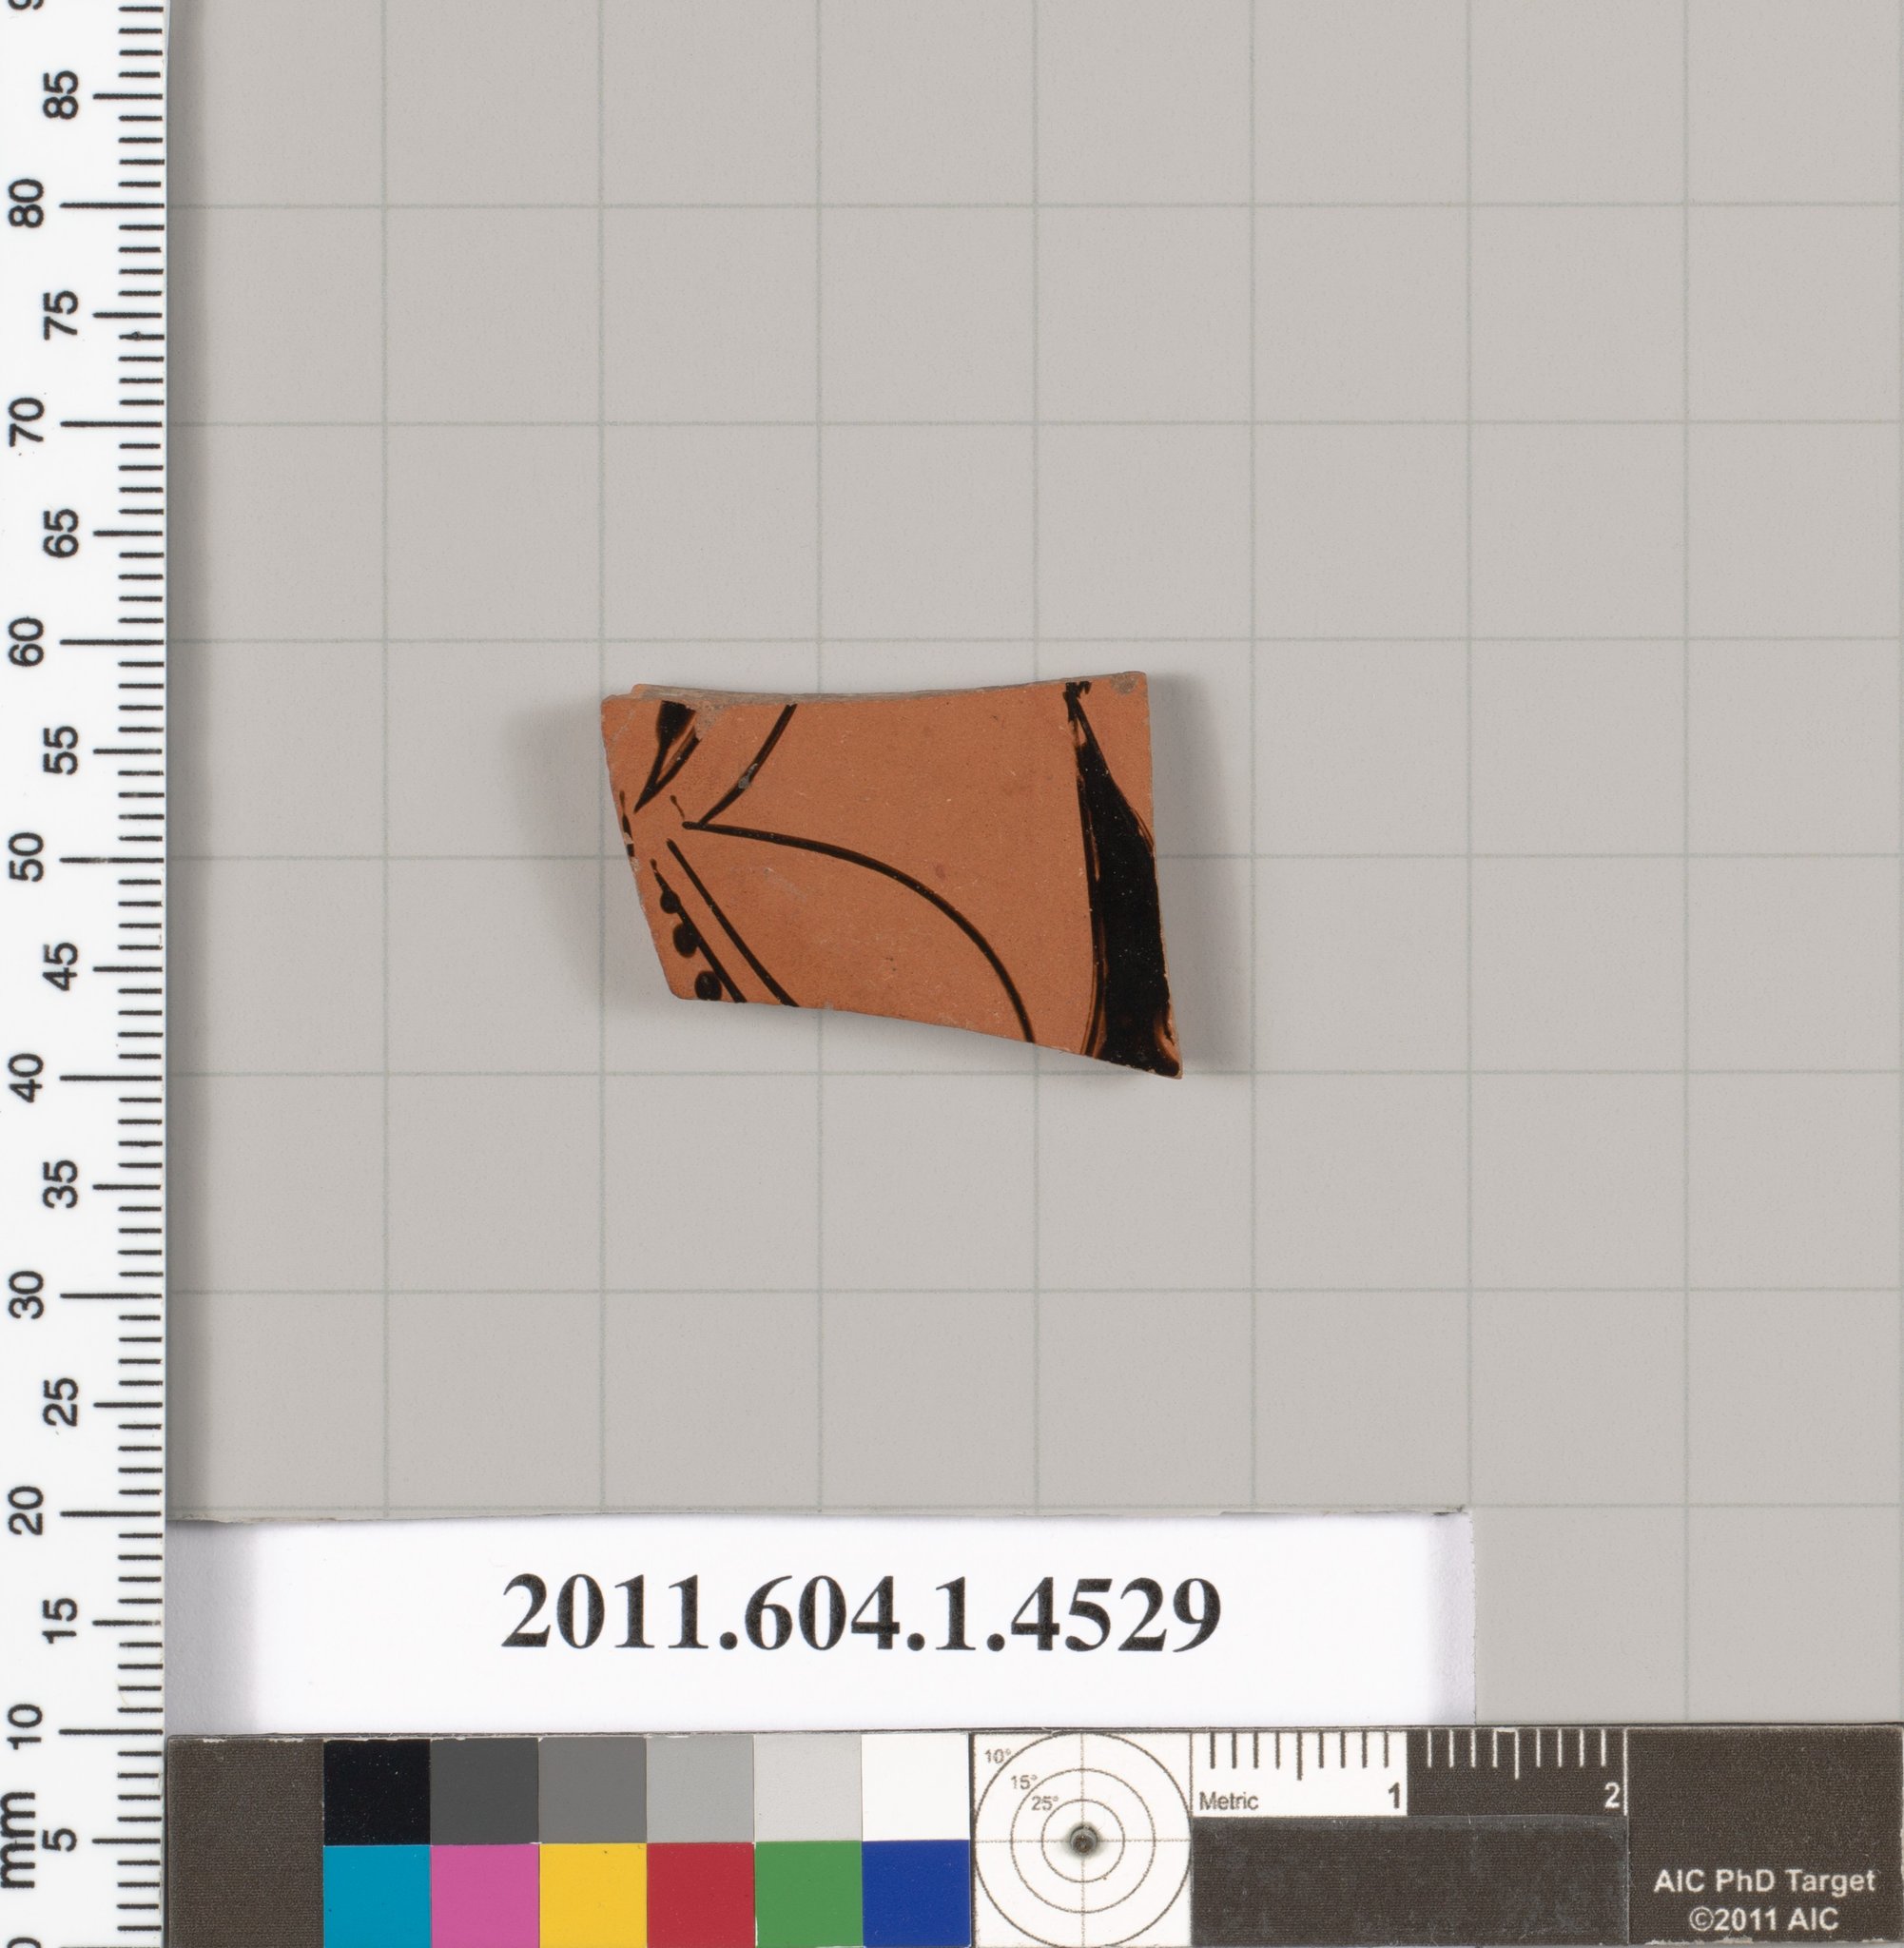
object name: kylix fragment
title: Terracotta fragment of a kylix (drinking cup)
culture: greek, attic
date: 500-480 BCE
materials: terracotta